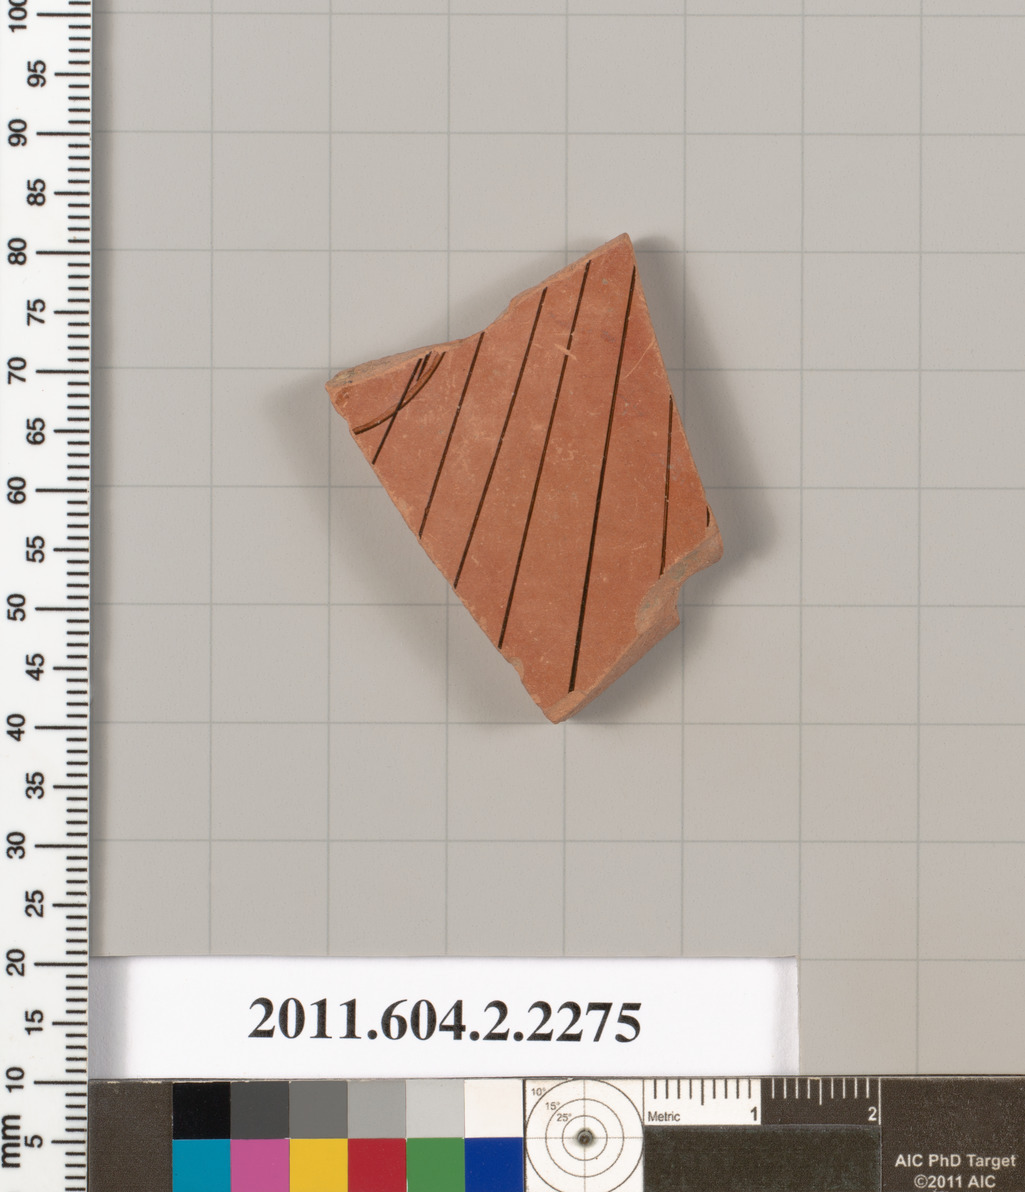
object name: pot fragment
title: Terracotta fragment of a pot; glazed on the inside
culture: greek, attic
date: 475-451 BCE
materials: terracotta